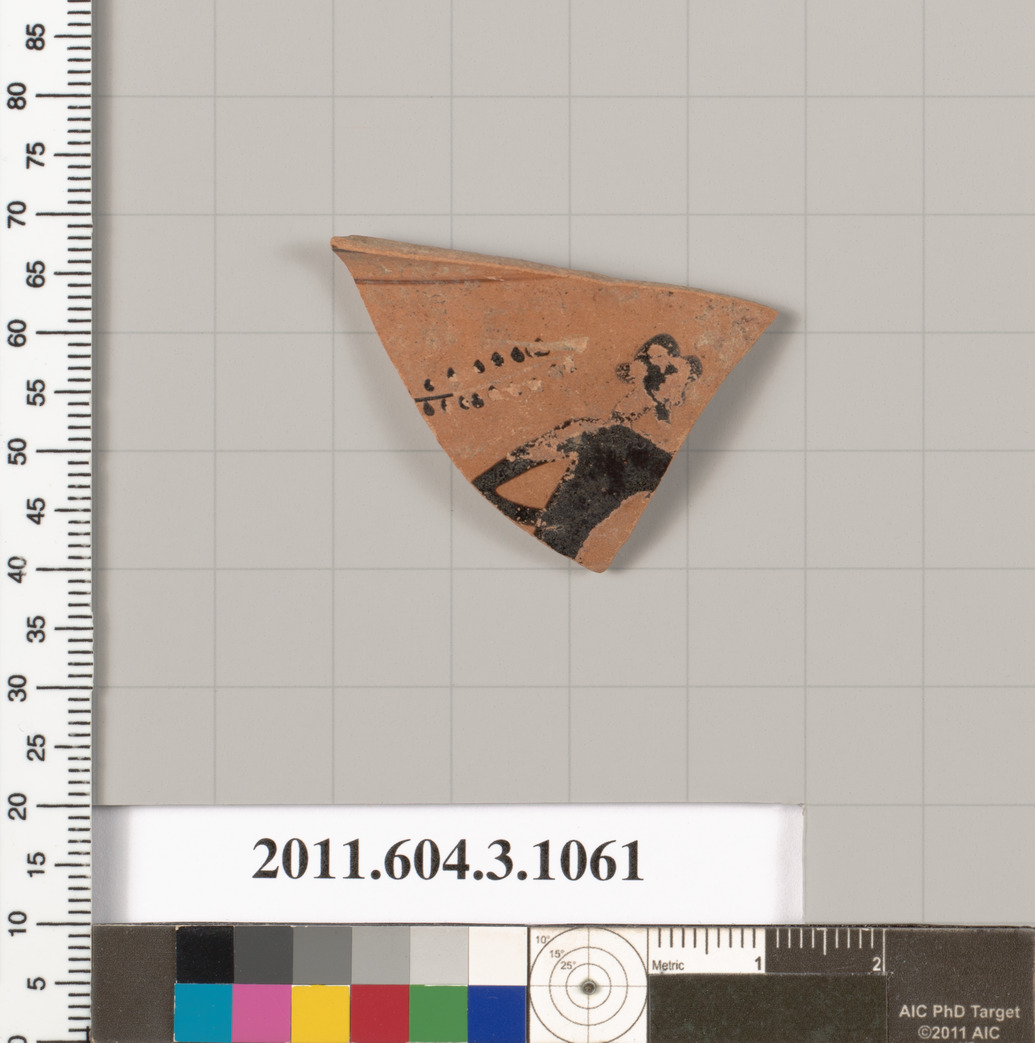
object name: mastoid fragment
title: Terracotta fragment of a mastoid (drinking cup with narrow base)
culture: greek, attic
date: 534-468 BCE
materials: terracotta